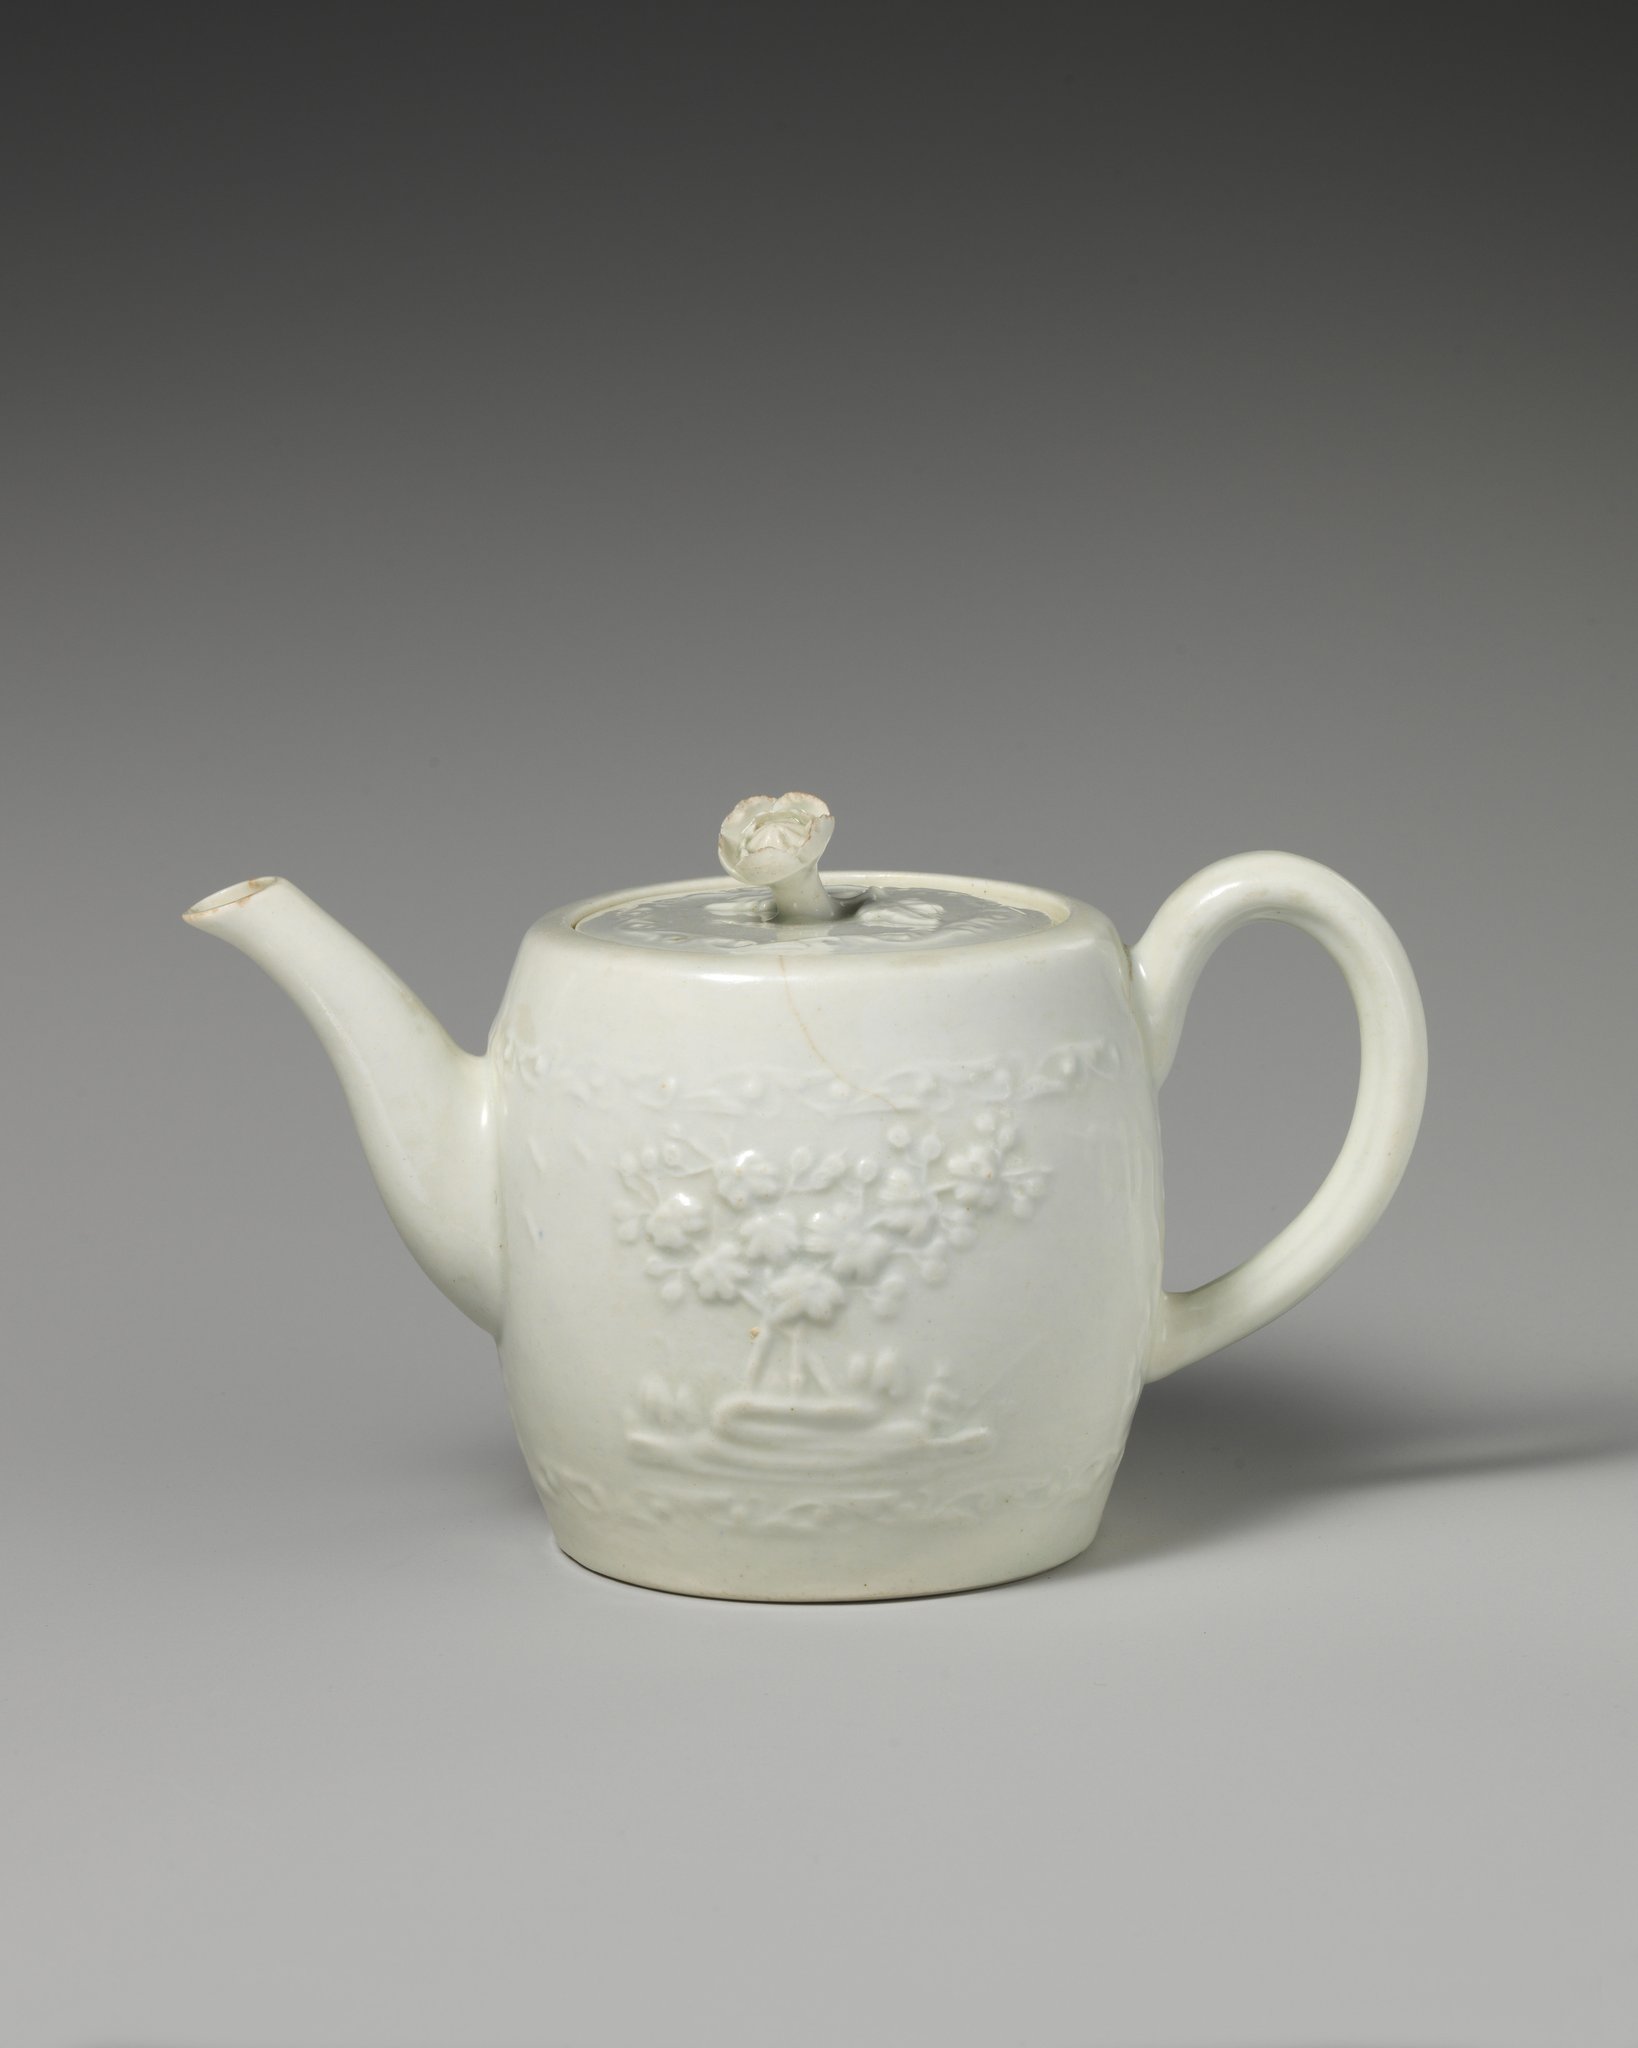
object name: teapot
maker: worcester factory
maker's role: factory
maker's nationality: british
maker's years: 1751-2008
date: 1760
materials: soft paste porcelain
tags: flowers